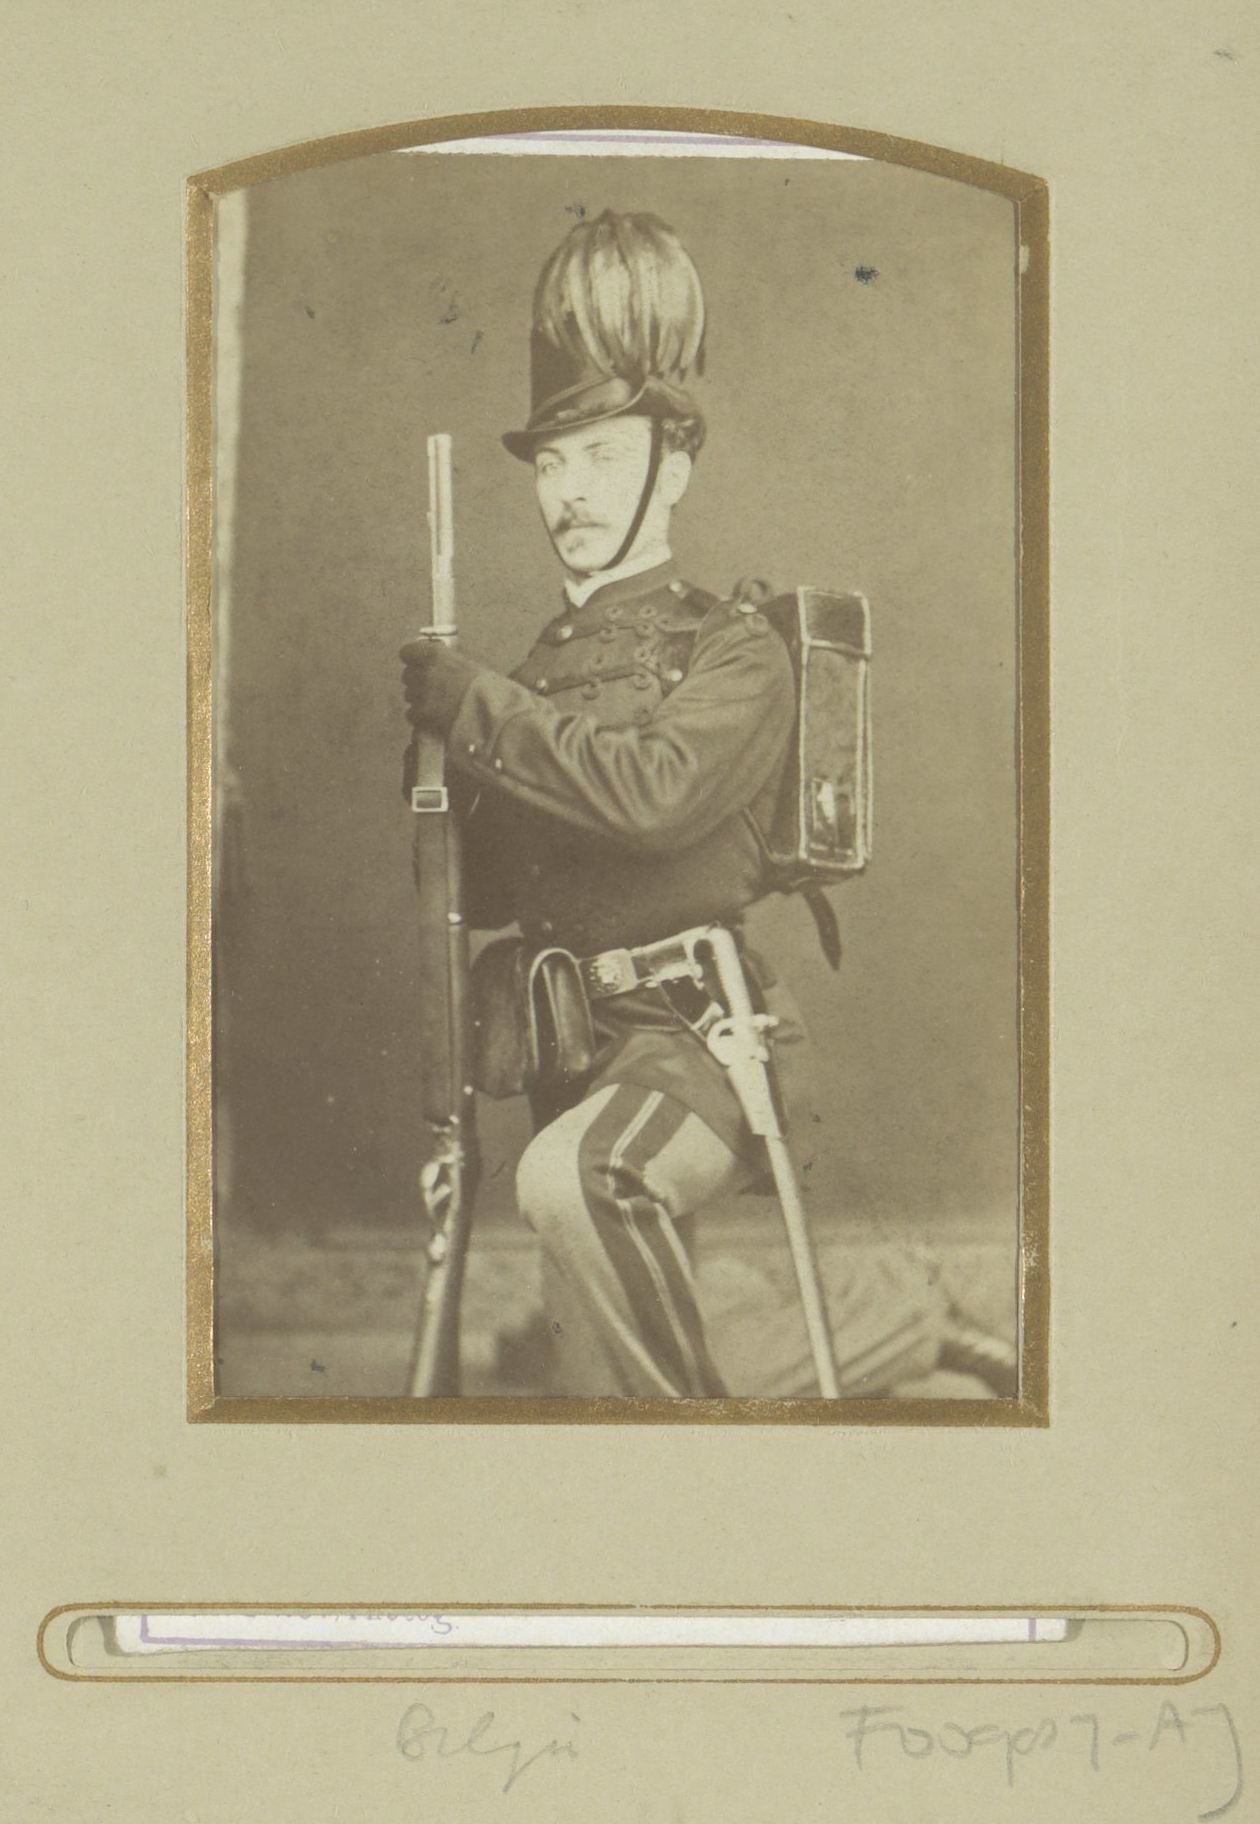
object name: carte de visite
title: Portret van een (vermoedelijk) Belgische militair, knielend met geweer en verenhoed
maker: charles emmanuel dhoy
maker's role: fotograaf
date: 1870-1892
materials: cardboard, paper, photographic support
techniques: albumen print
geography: ghent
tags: head-gear: hat, firearms: rifle, warfare; military affairs, (military) uniforms, division of armed forces, ghent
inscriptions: address: ‘Rue courte du jour 25 près du Pont Madou Walpoort Brug Gand’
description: Onderdeel van Album met cartes-de-visite en kabinetfoto's van militairen in uniform.